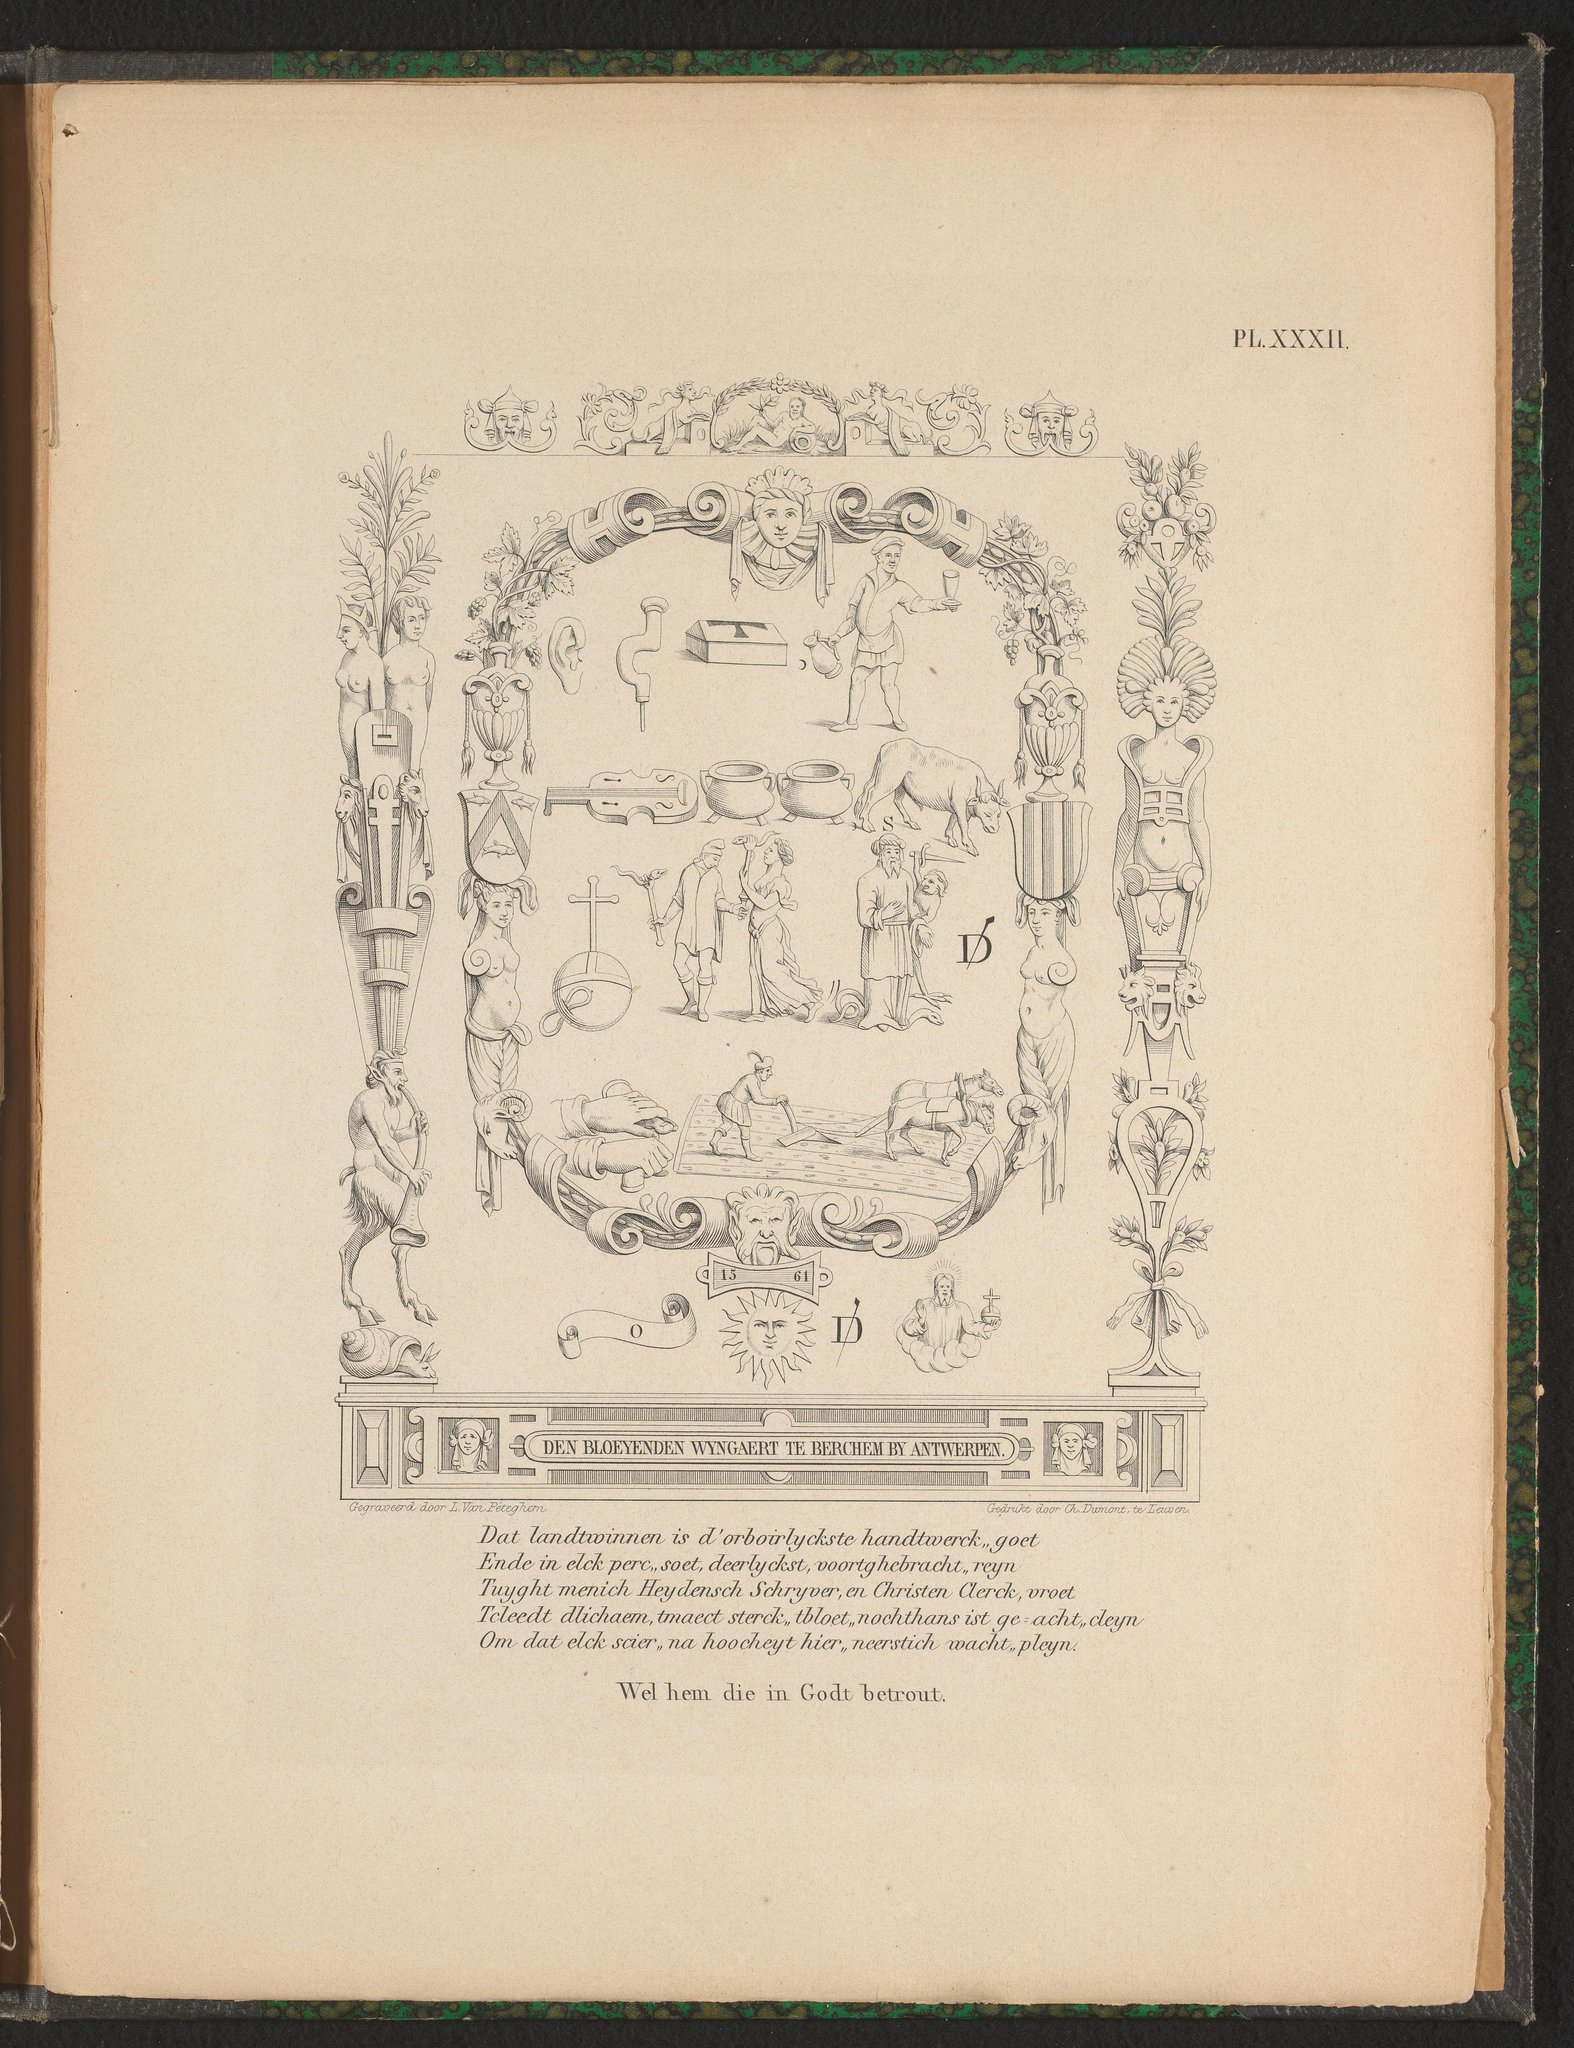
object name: historical object representation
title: Rebus van De Bloeiende Wijngaard (Berchem), 1561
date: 1859-1861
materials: paper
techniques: lithograph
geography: leuven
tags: chamber of rhetoric (dutch: 'rederijkerskamer'), rebus, antwerp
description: Rebus van De Bloeiende Wijngaard, rederijkerskamers van Berchem, 1561. Plaat XXXII in een map met 35 genummerde platen, de meeste naar de illustraties in de oorspronkelijke uitgave van het Landjuweel van Antwerpen in 1561.